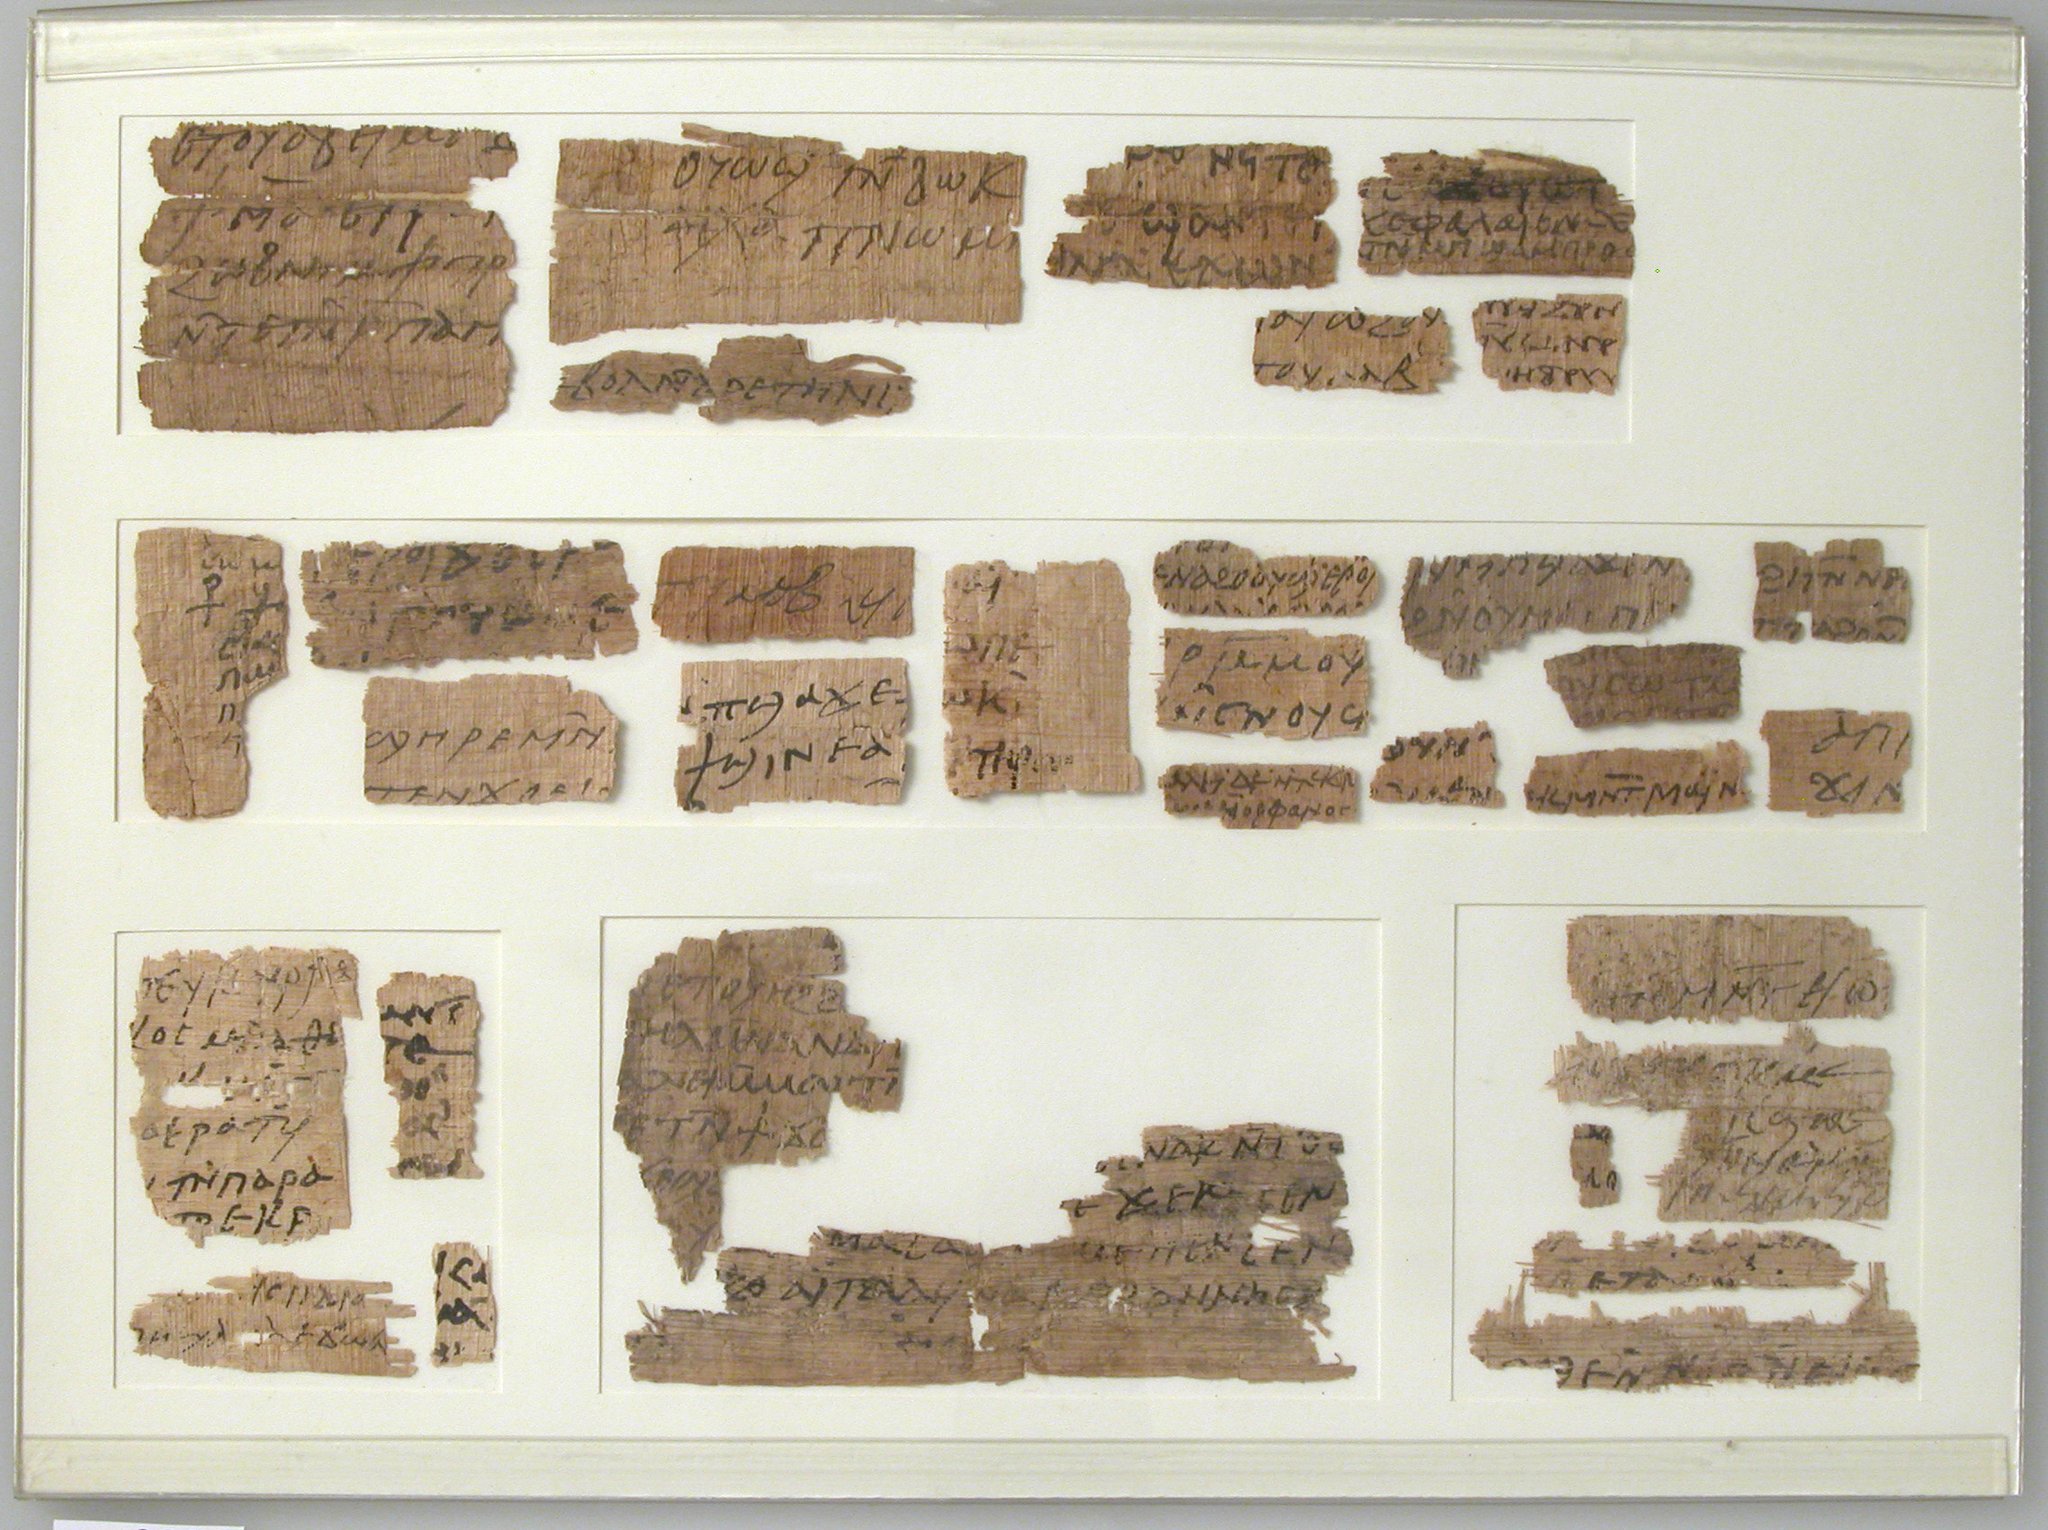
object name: fragment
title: Papyri Fragments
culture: coptic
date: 601-700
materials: ink, papyrus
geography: egypt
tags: documents